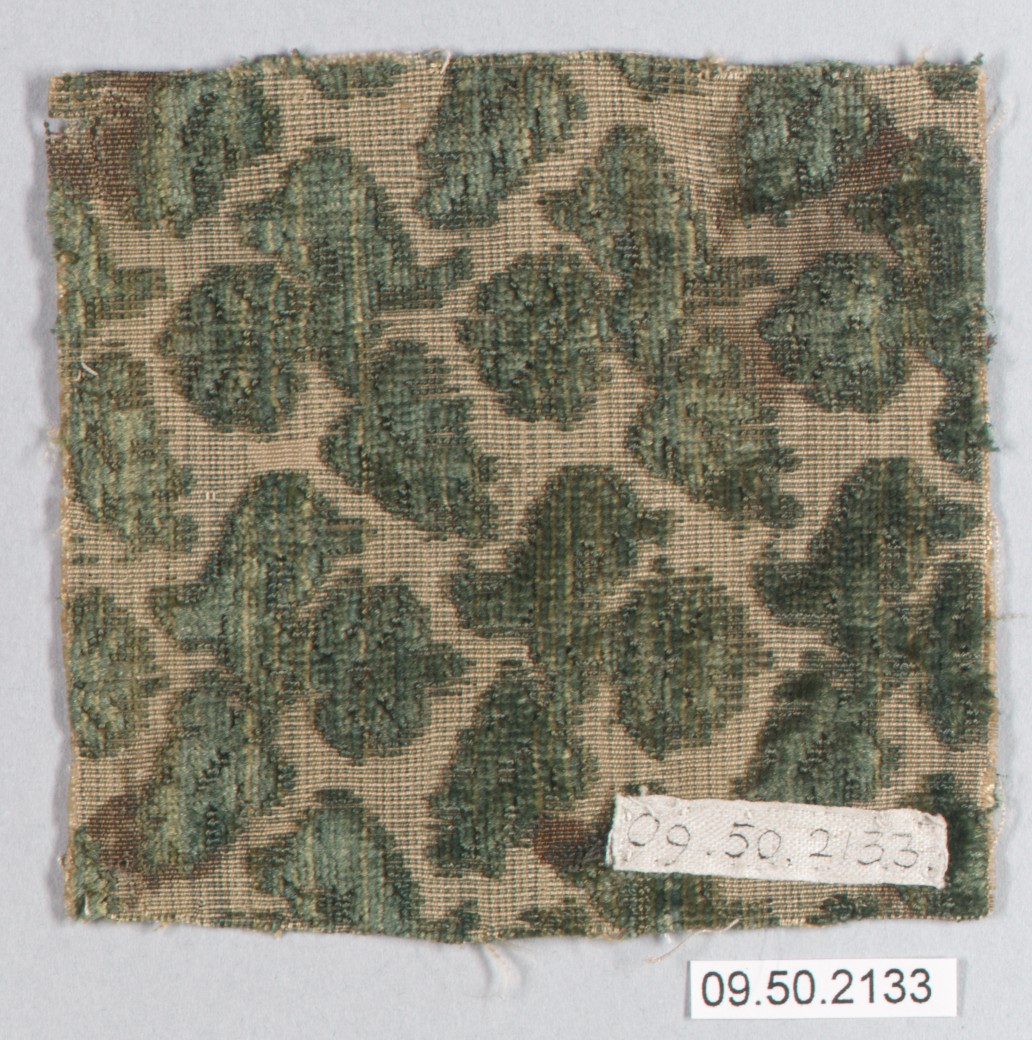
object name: piece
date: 1501-1700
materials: silk